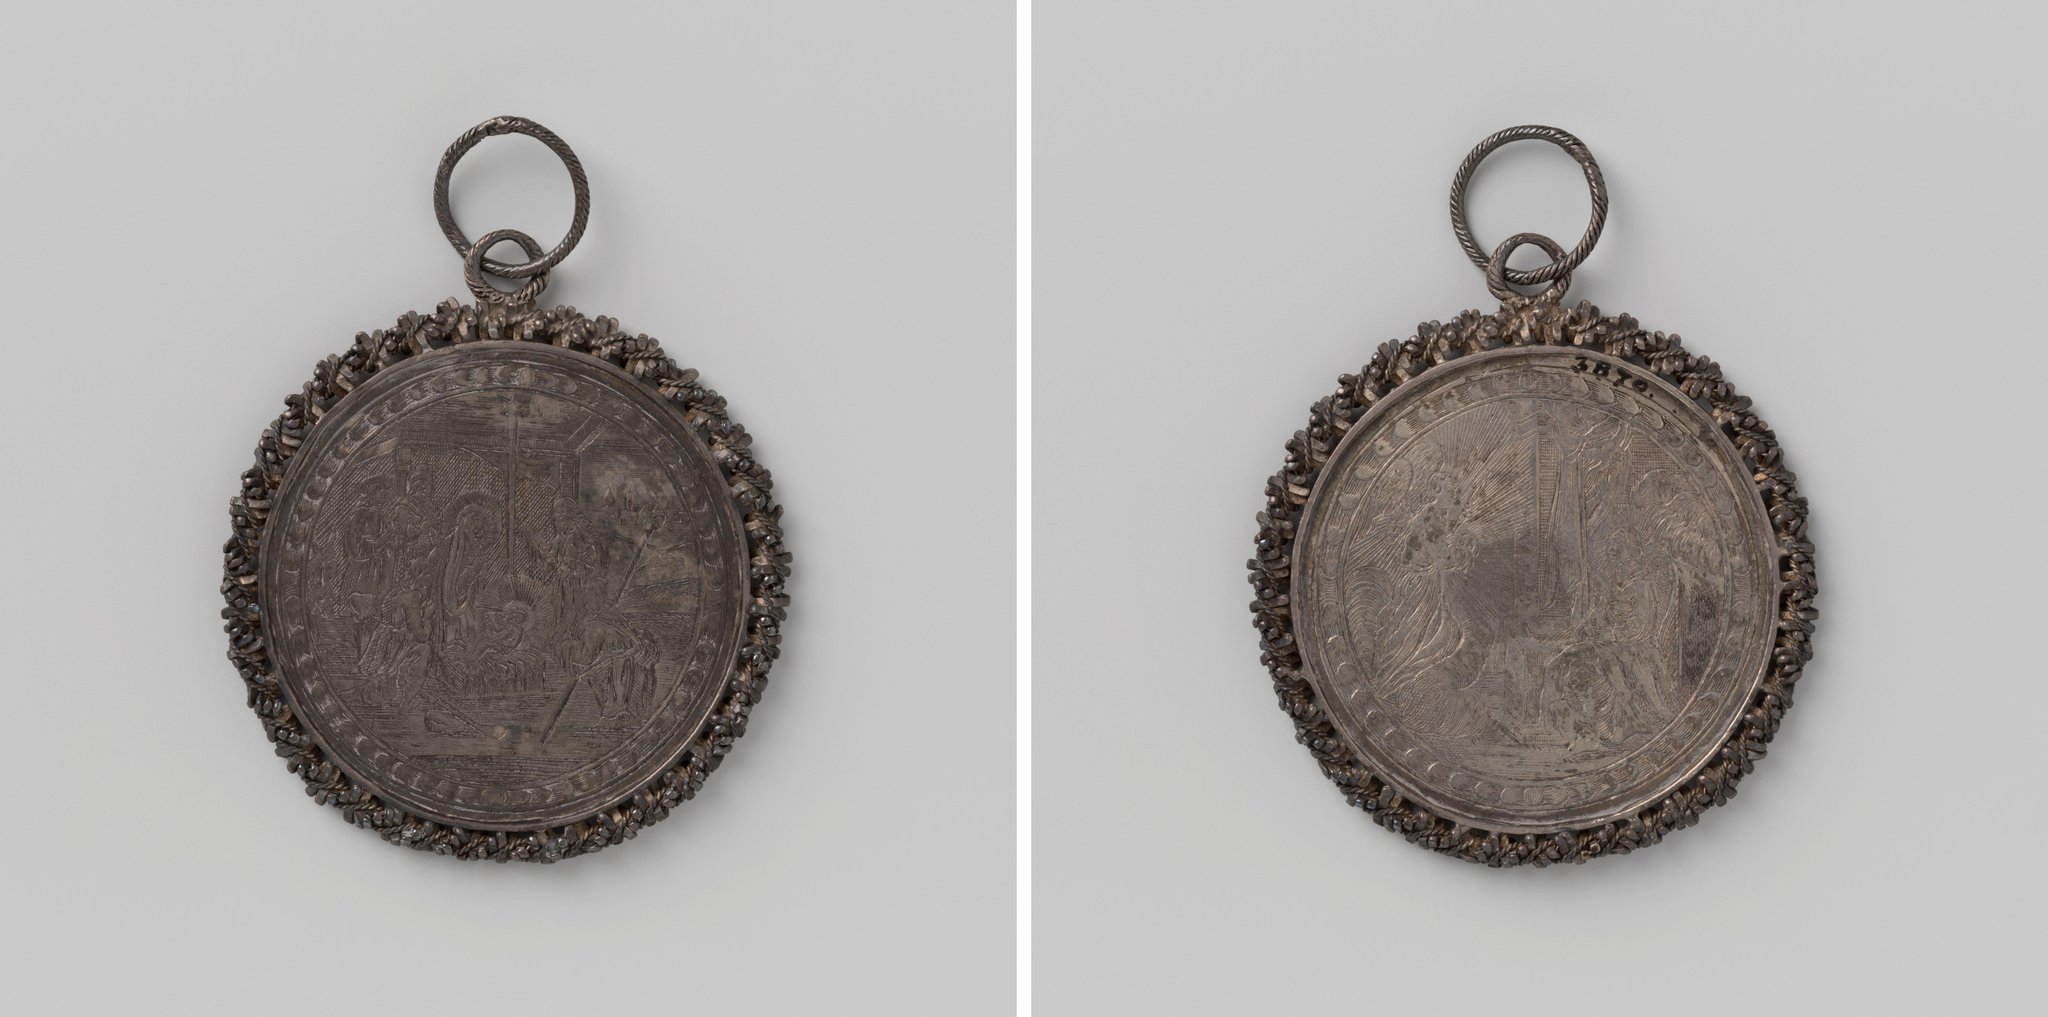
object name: medal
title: Penning met verschijning van de engel aan Maria en de aanbidding van het Christuskind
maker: Anonymous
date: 1600-1699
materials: silver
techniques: engraving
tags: the annunciation: mary, usually reading, is visited by the angel (sometimes a woman overhears the conversation)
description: Zilveren penning aan draagoog en draagring in opengewerkte rand. Voorzijde: engel met scepter in hand in stralenkrans, staande op wolken voor vrouw, die naast lessenaar zit binnen sierrand. Keerzijde: Christuskind in kribbe in stralenkrans, beschenen door ster aan hemel; daaromheen vijf mannen, vrouw met aureool en dieren binnen sierrand